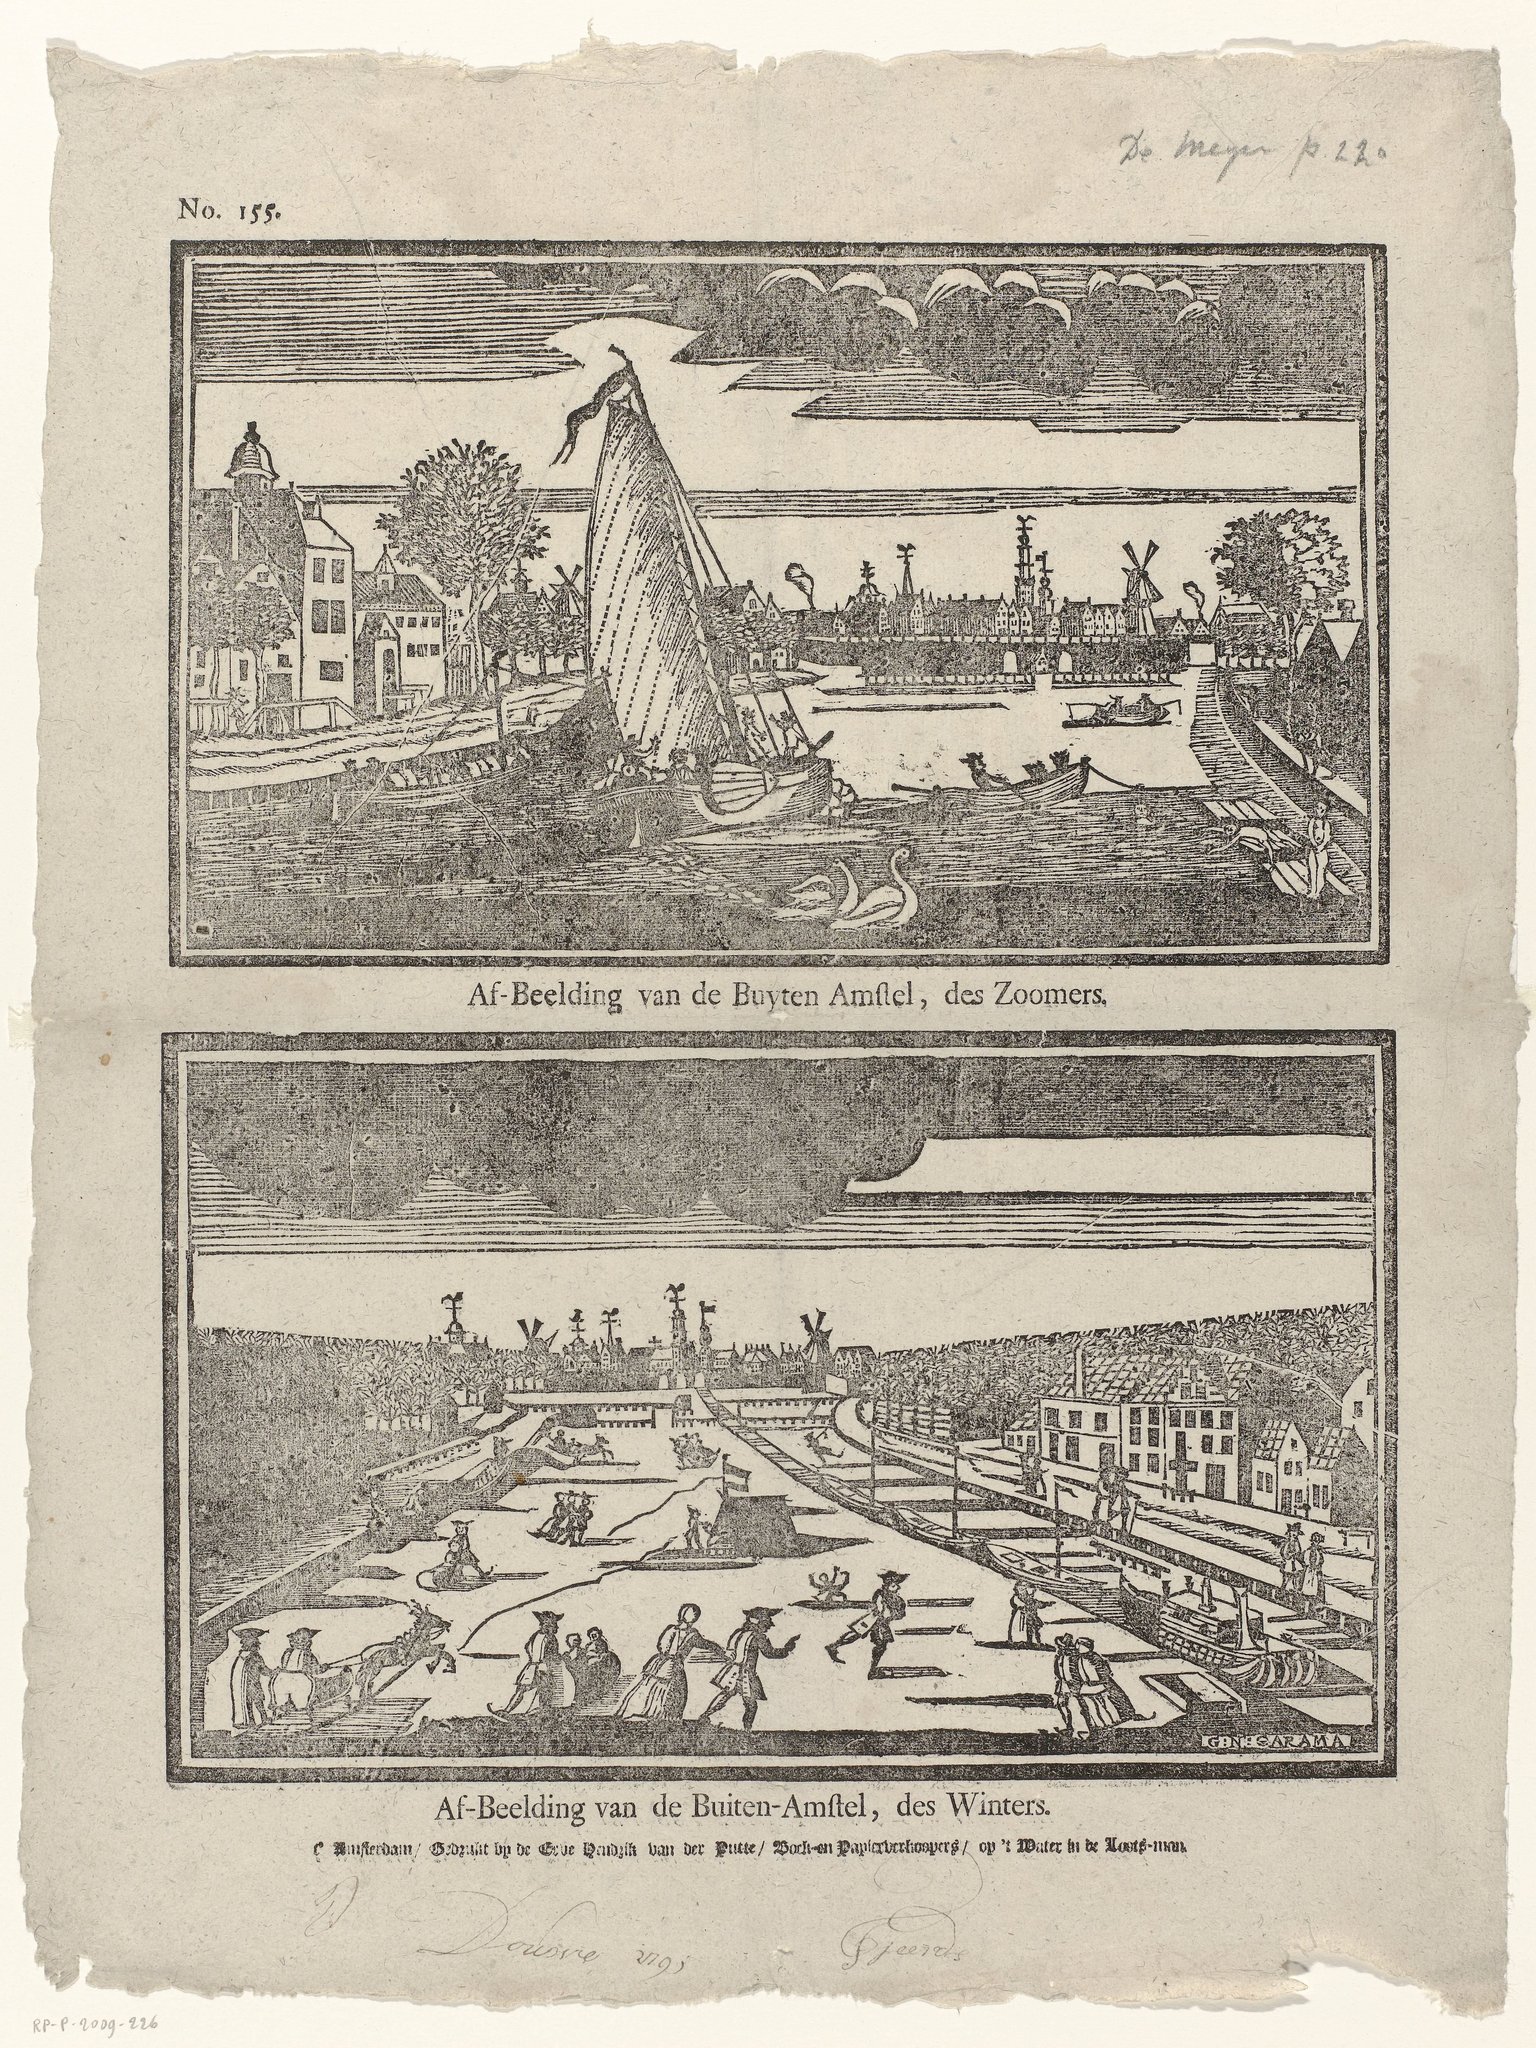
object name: print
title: Af-beelding van de Buyten Amstel, des zoomers / Af-beelding van de Buyten Amstel, des winters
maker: g.n. garama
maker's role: houtsnijder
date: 1767-1793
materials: paper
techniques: letterpress printing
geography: netherlands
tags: city-view, and landscape with man-made constructions, amsterdam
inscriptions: collector's mark: Lugt 2228, collector's mark: Lugt 2760, inscription: ‘D Dou[...]e [...]95 / Tjeerds’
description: Blad met 2 voorstellingen. Boven een gezicht op de Amstel en Amsterdam in de zomer met boten en zwemmers. Onder een gezicht op de Amstel en Amsterdam met schaatsers en boten varend in een opengebroken vaargeul. Onder elke afbeelding de titel. Genummerd linksboven: No. 155.